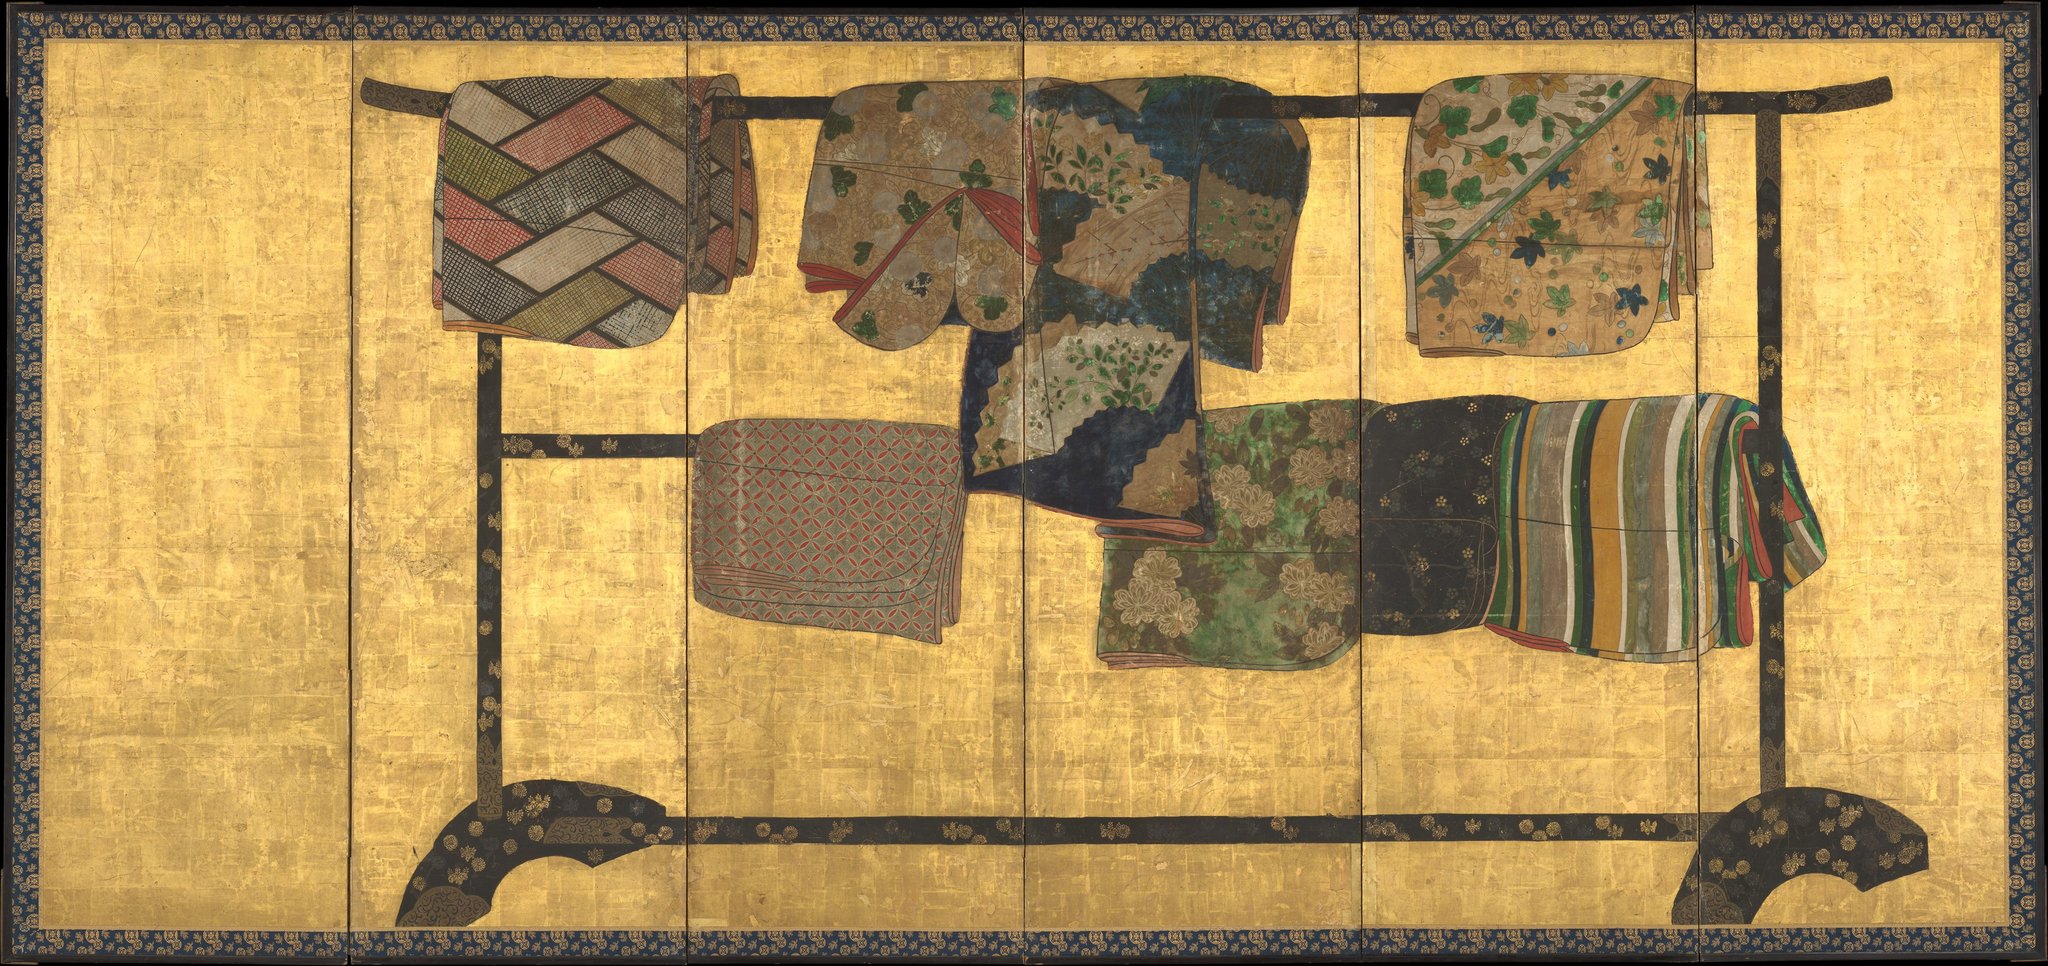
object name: screen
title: Tagasode (“Whose Sleeves?”)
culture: japanese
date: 1601-1650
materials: gold, gold leaf, ink, panel, paper, silver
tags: robes